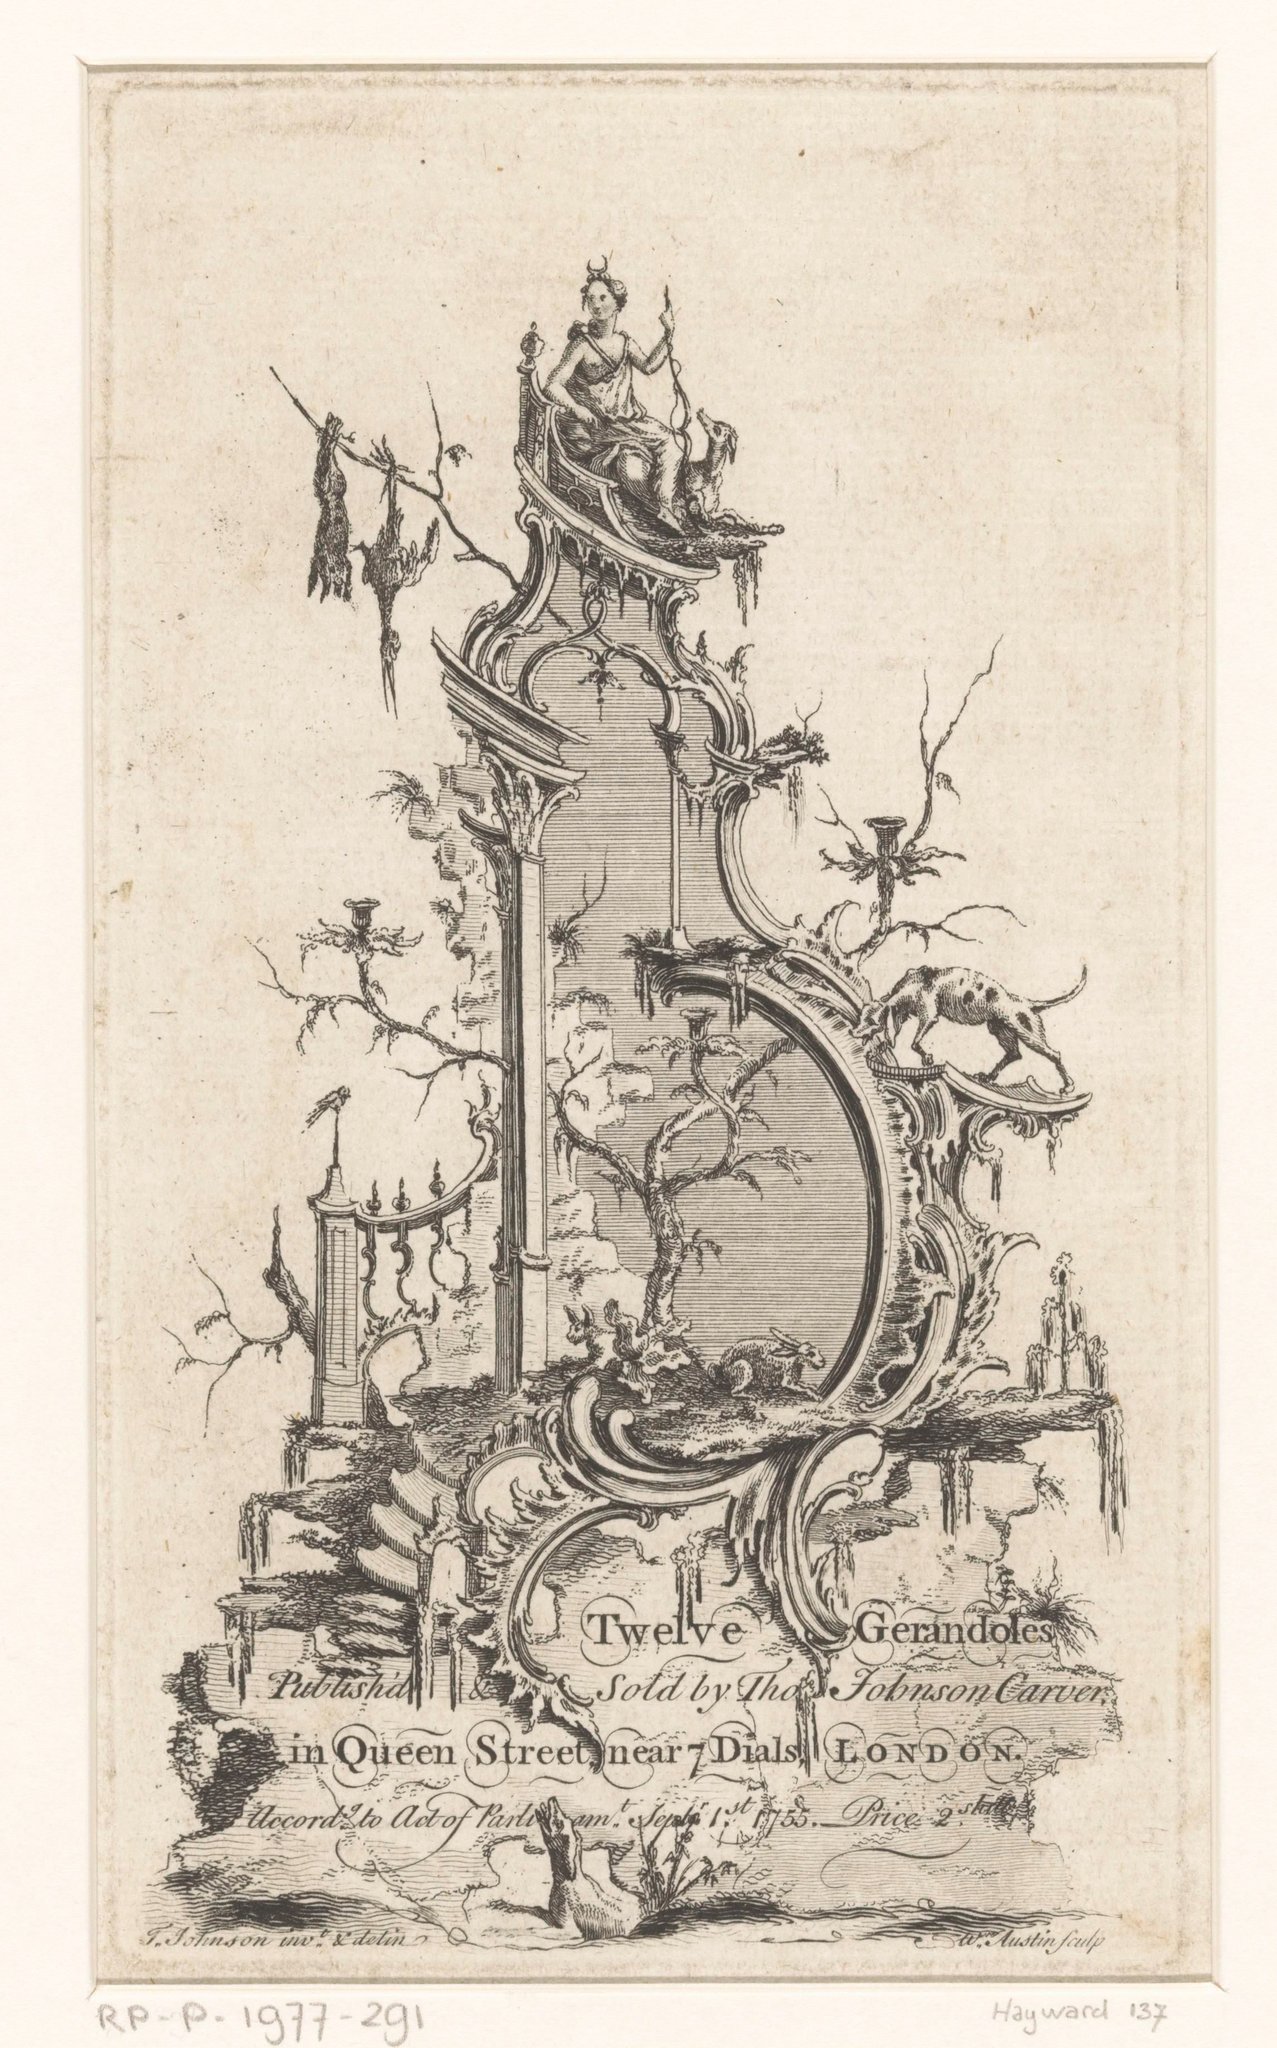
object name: ornament print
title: Twelve gerandoles (...)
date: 1755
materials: paper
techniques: engraving, etching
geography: london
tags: (story of) diana (artemis), chandelier, candelabrum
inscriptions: collector's mark: Lugt 2760, collector's mark: Lugt 2228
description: Een geornamenteerde girandole bekroond met Diana. Gedecoreerd met takken, jachthonden en een jachtbuit.